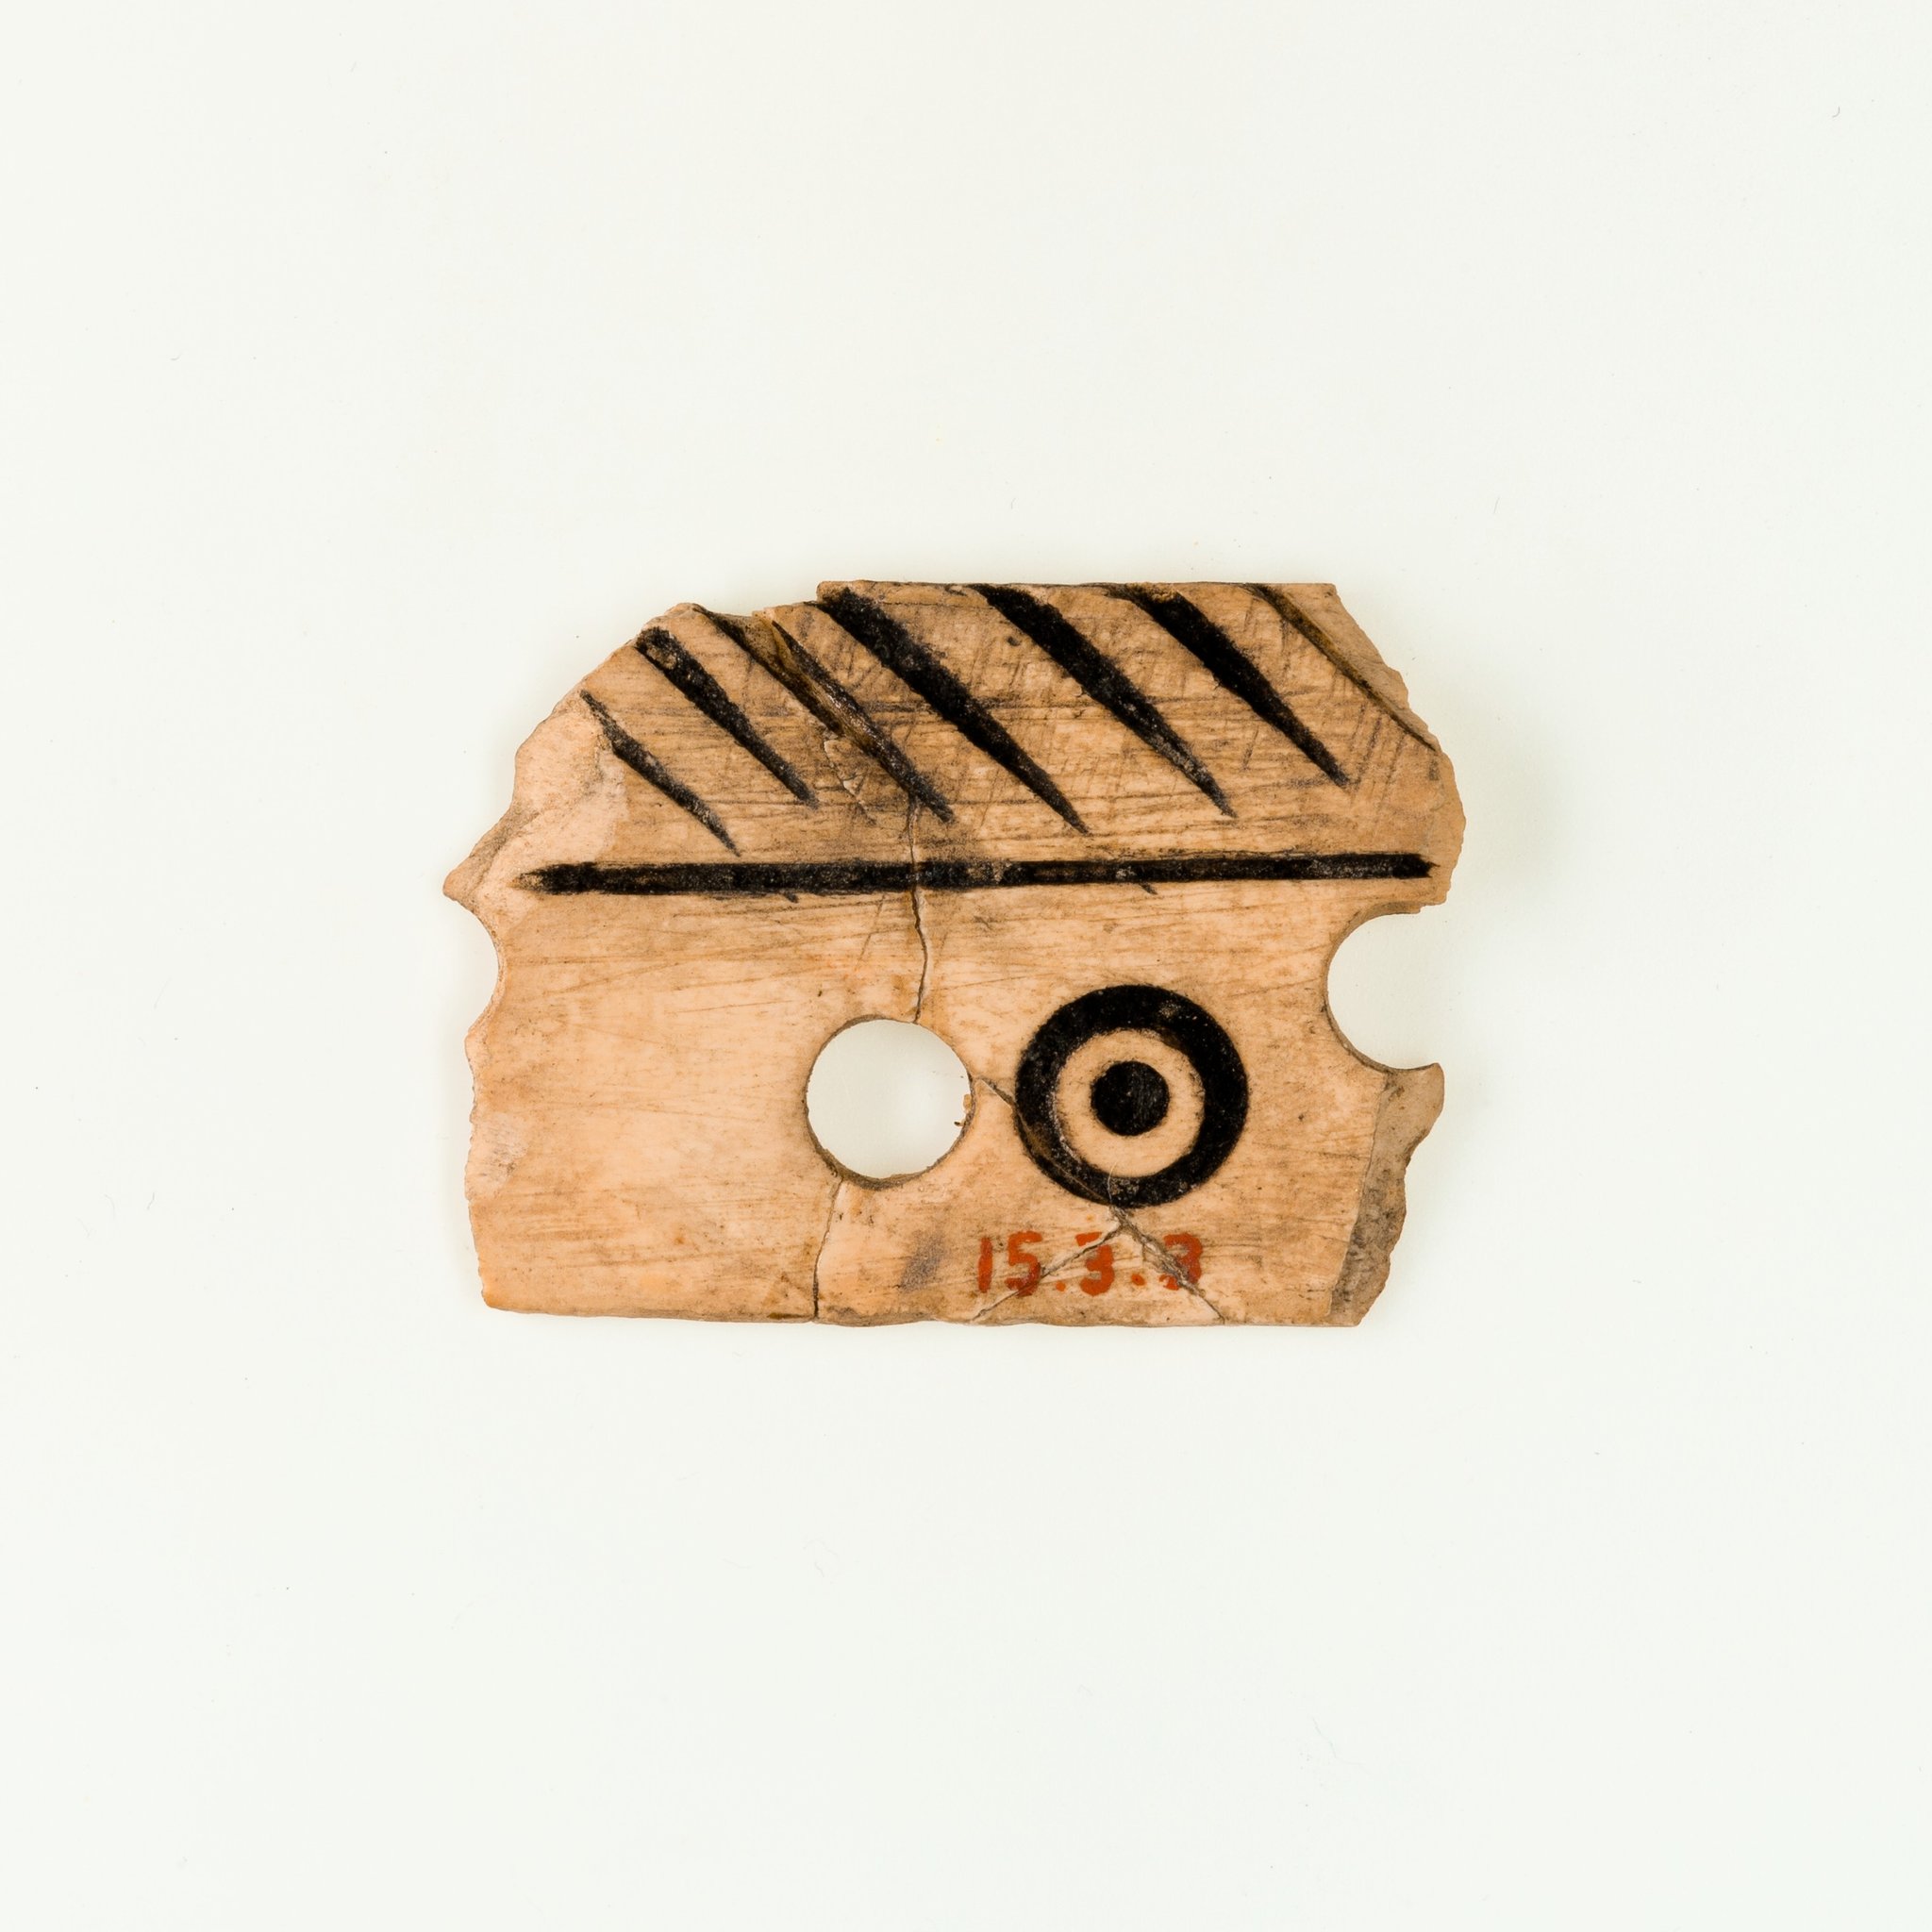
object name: inlay fragment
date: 1981-1640 BCE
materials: bone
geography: egypt